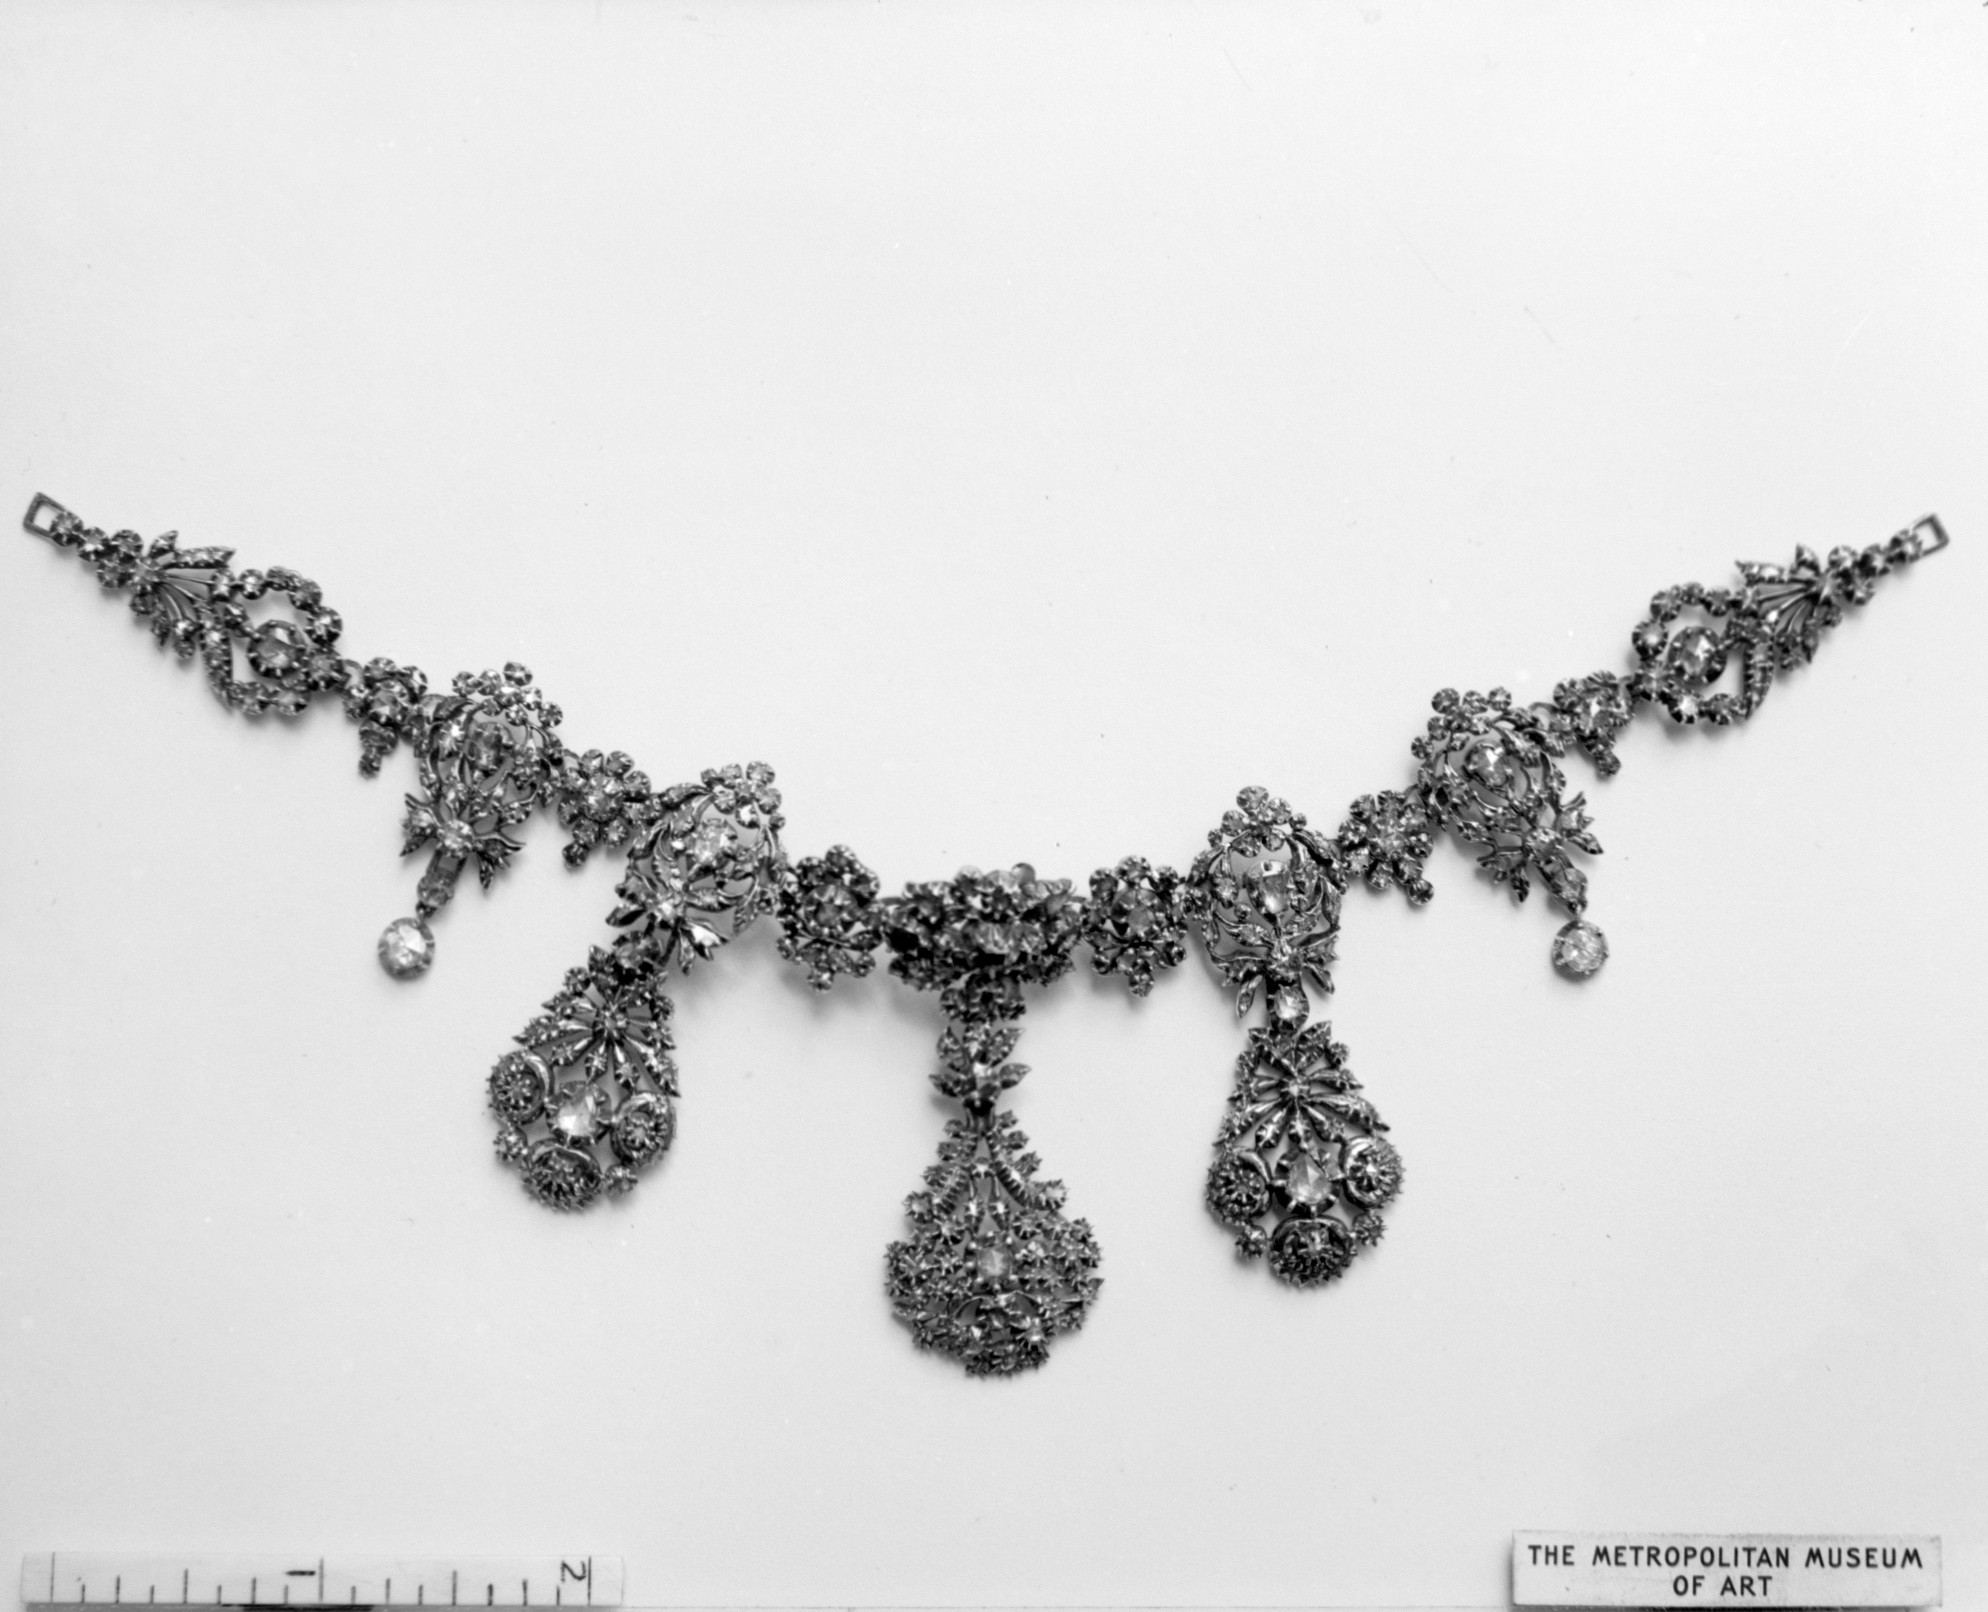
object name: necklace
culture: french or italian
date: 1701-1800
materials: diamond, gold, silver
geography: italy